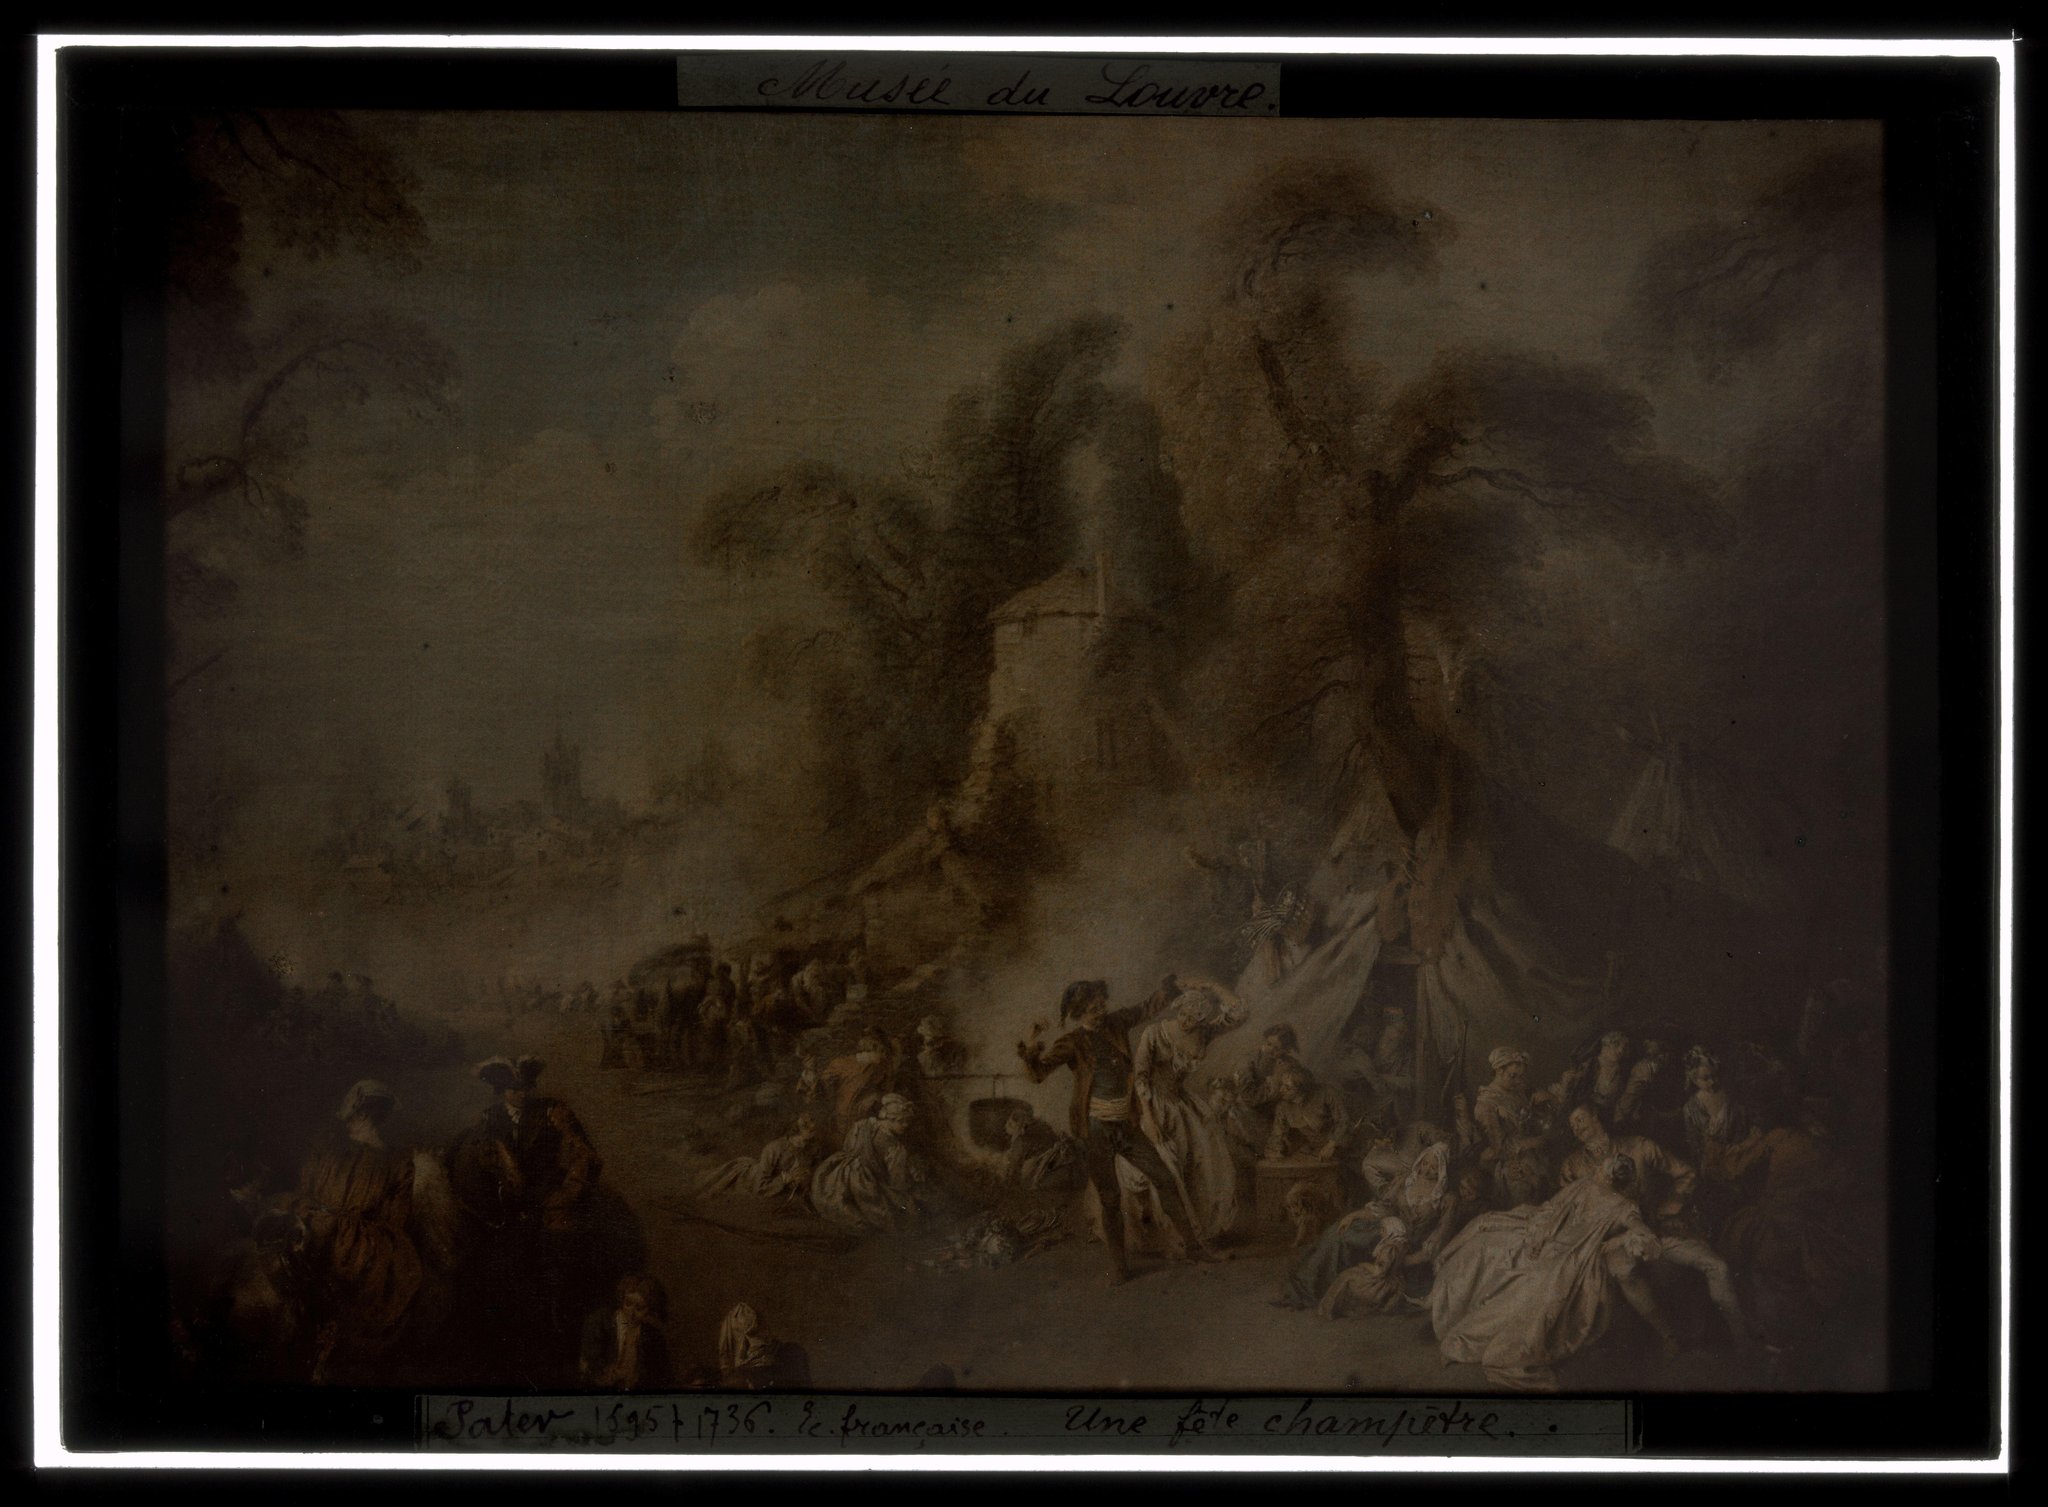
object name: photograph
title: Reproductie van Jean-Baptiste Pater, Une fête champêtre, Louvre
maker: Anonymous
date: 1907-1935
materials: glass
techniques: autochrome process, slide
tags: picture, painting